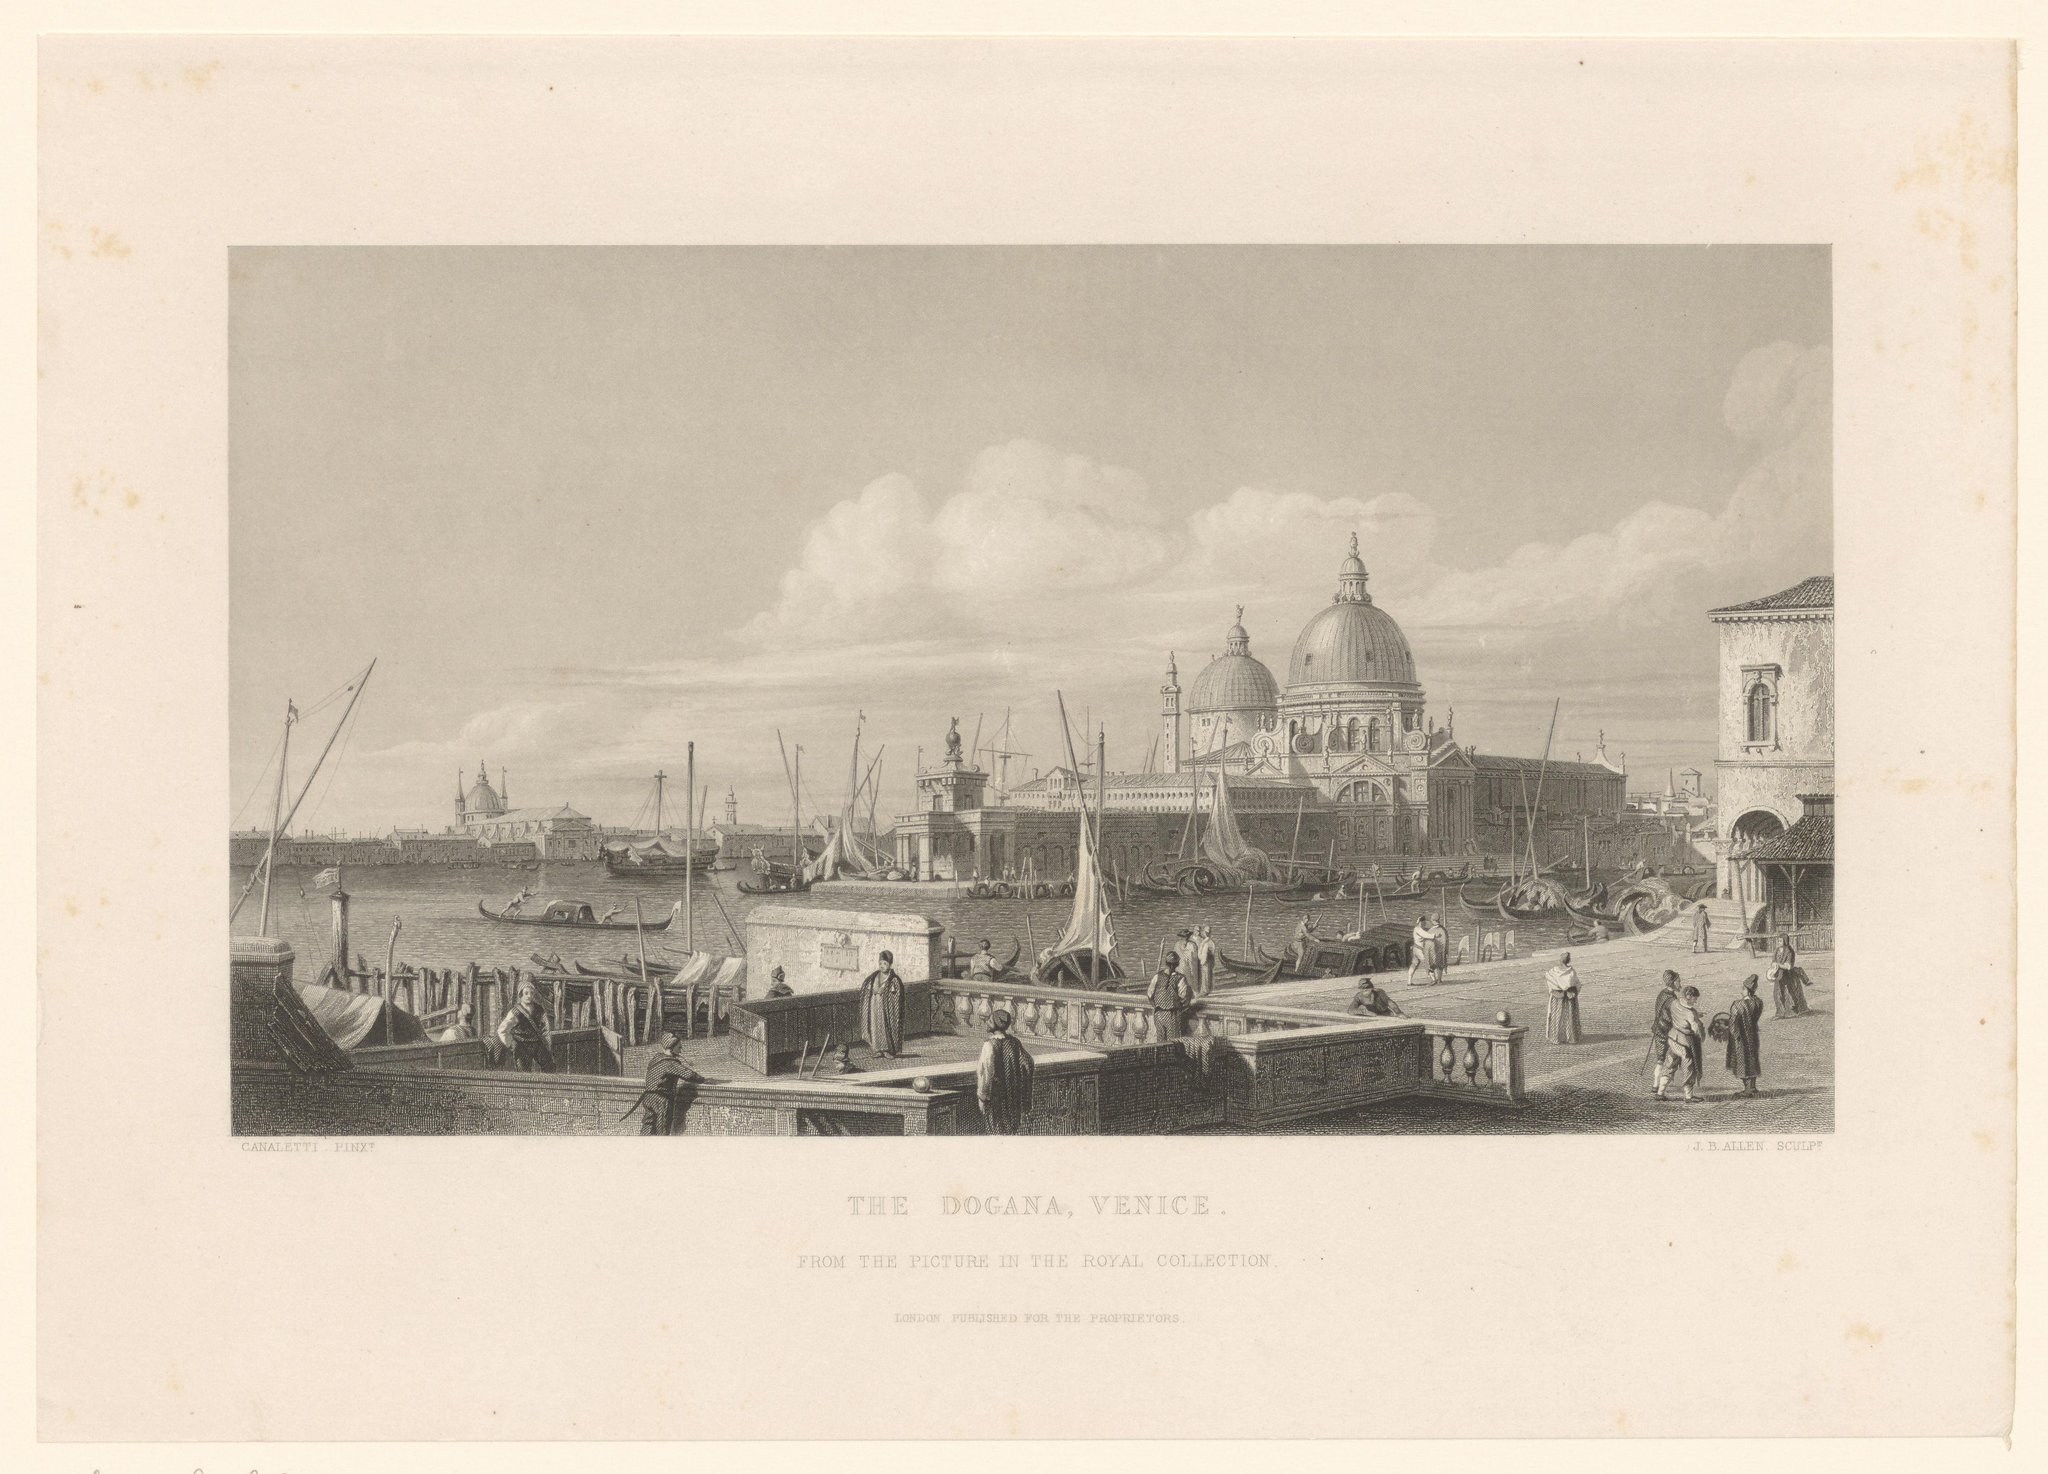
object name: print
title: Gezicht op de Dogana da Mar te Venetië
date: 1855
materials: paper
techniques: engraving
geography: london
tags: gondola, city-view in general; 'veduta' (+ city(-scape) with figures, staffage), canals, waters (in city) (+ city(-scape) with figures, staffage)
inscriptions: collector's mark: Lugt 2228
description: Prent uit: The Art Journal, 1855, tussen p. 248 en 249.